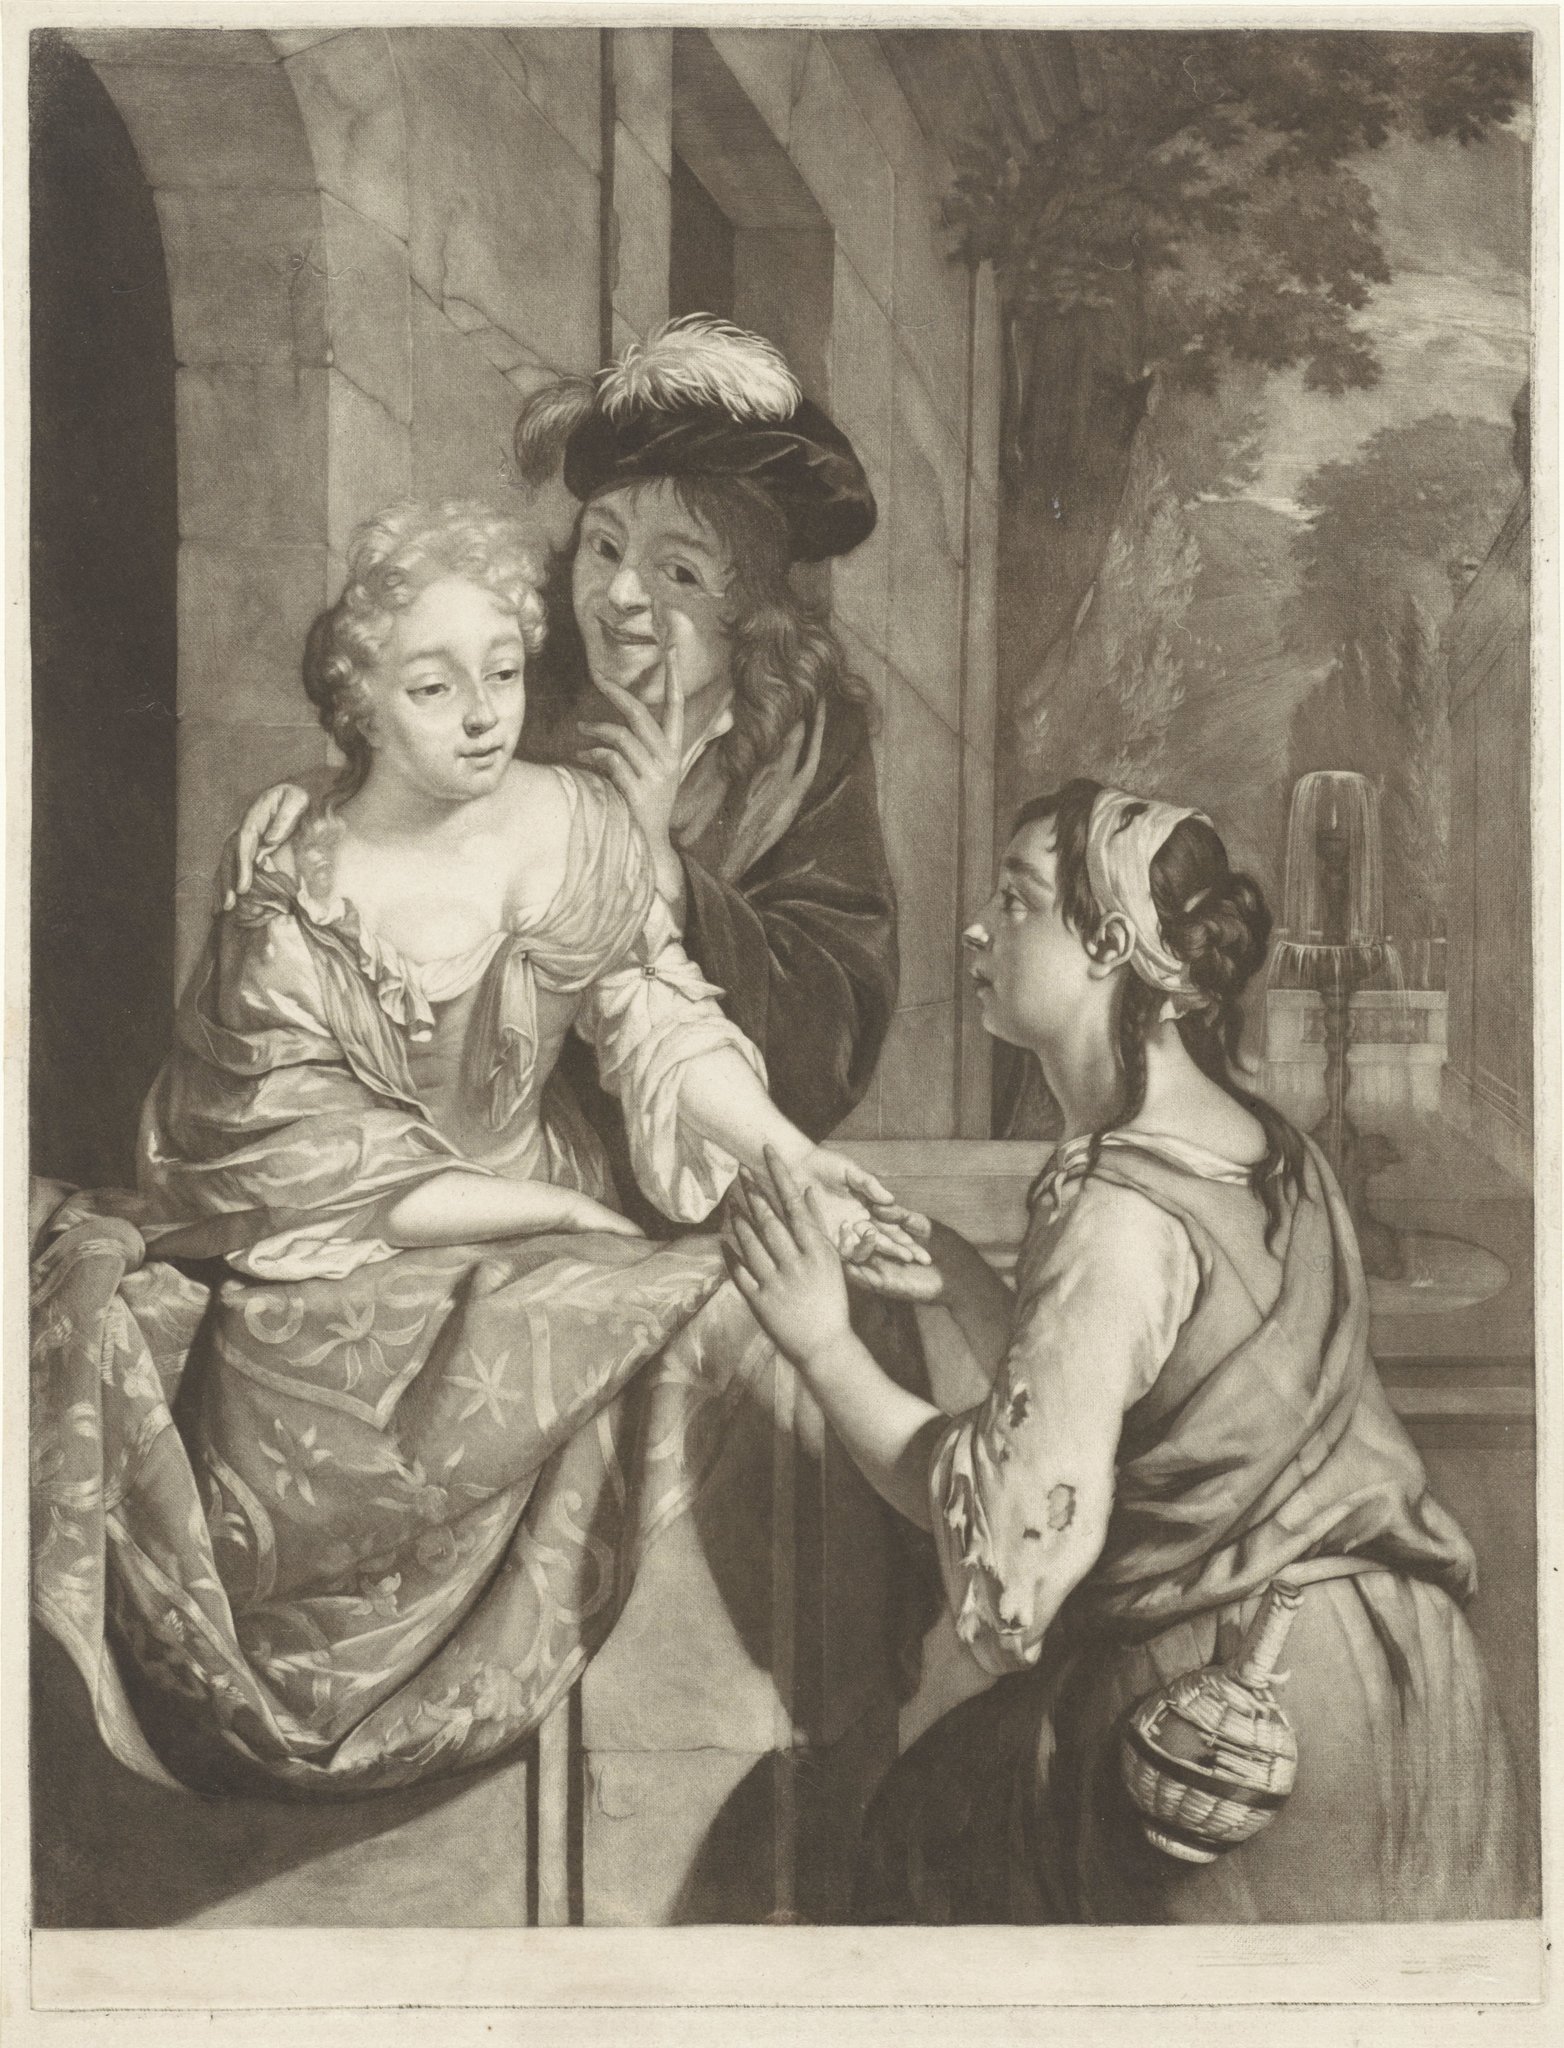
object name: print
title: Waarzegster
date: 1683-1726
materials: paper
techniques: mezzotint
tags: garden fountain, fortune-teller ~ pleasure fair and circus, divination ~ human corpse, necromancy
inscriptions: collector's mark: Lugt 240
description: Voor de ingang van een huis leest een waarzegster de hand van een jonge vrouw, terwijl de man die naast haar staat haar iets in het oor fluistert. Op de achtergrond een fontein.